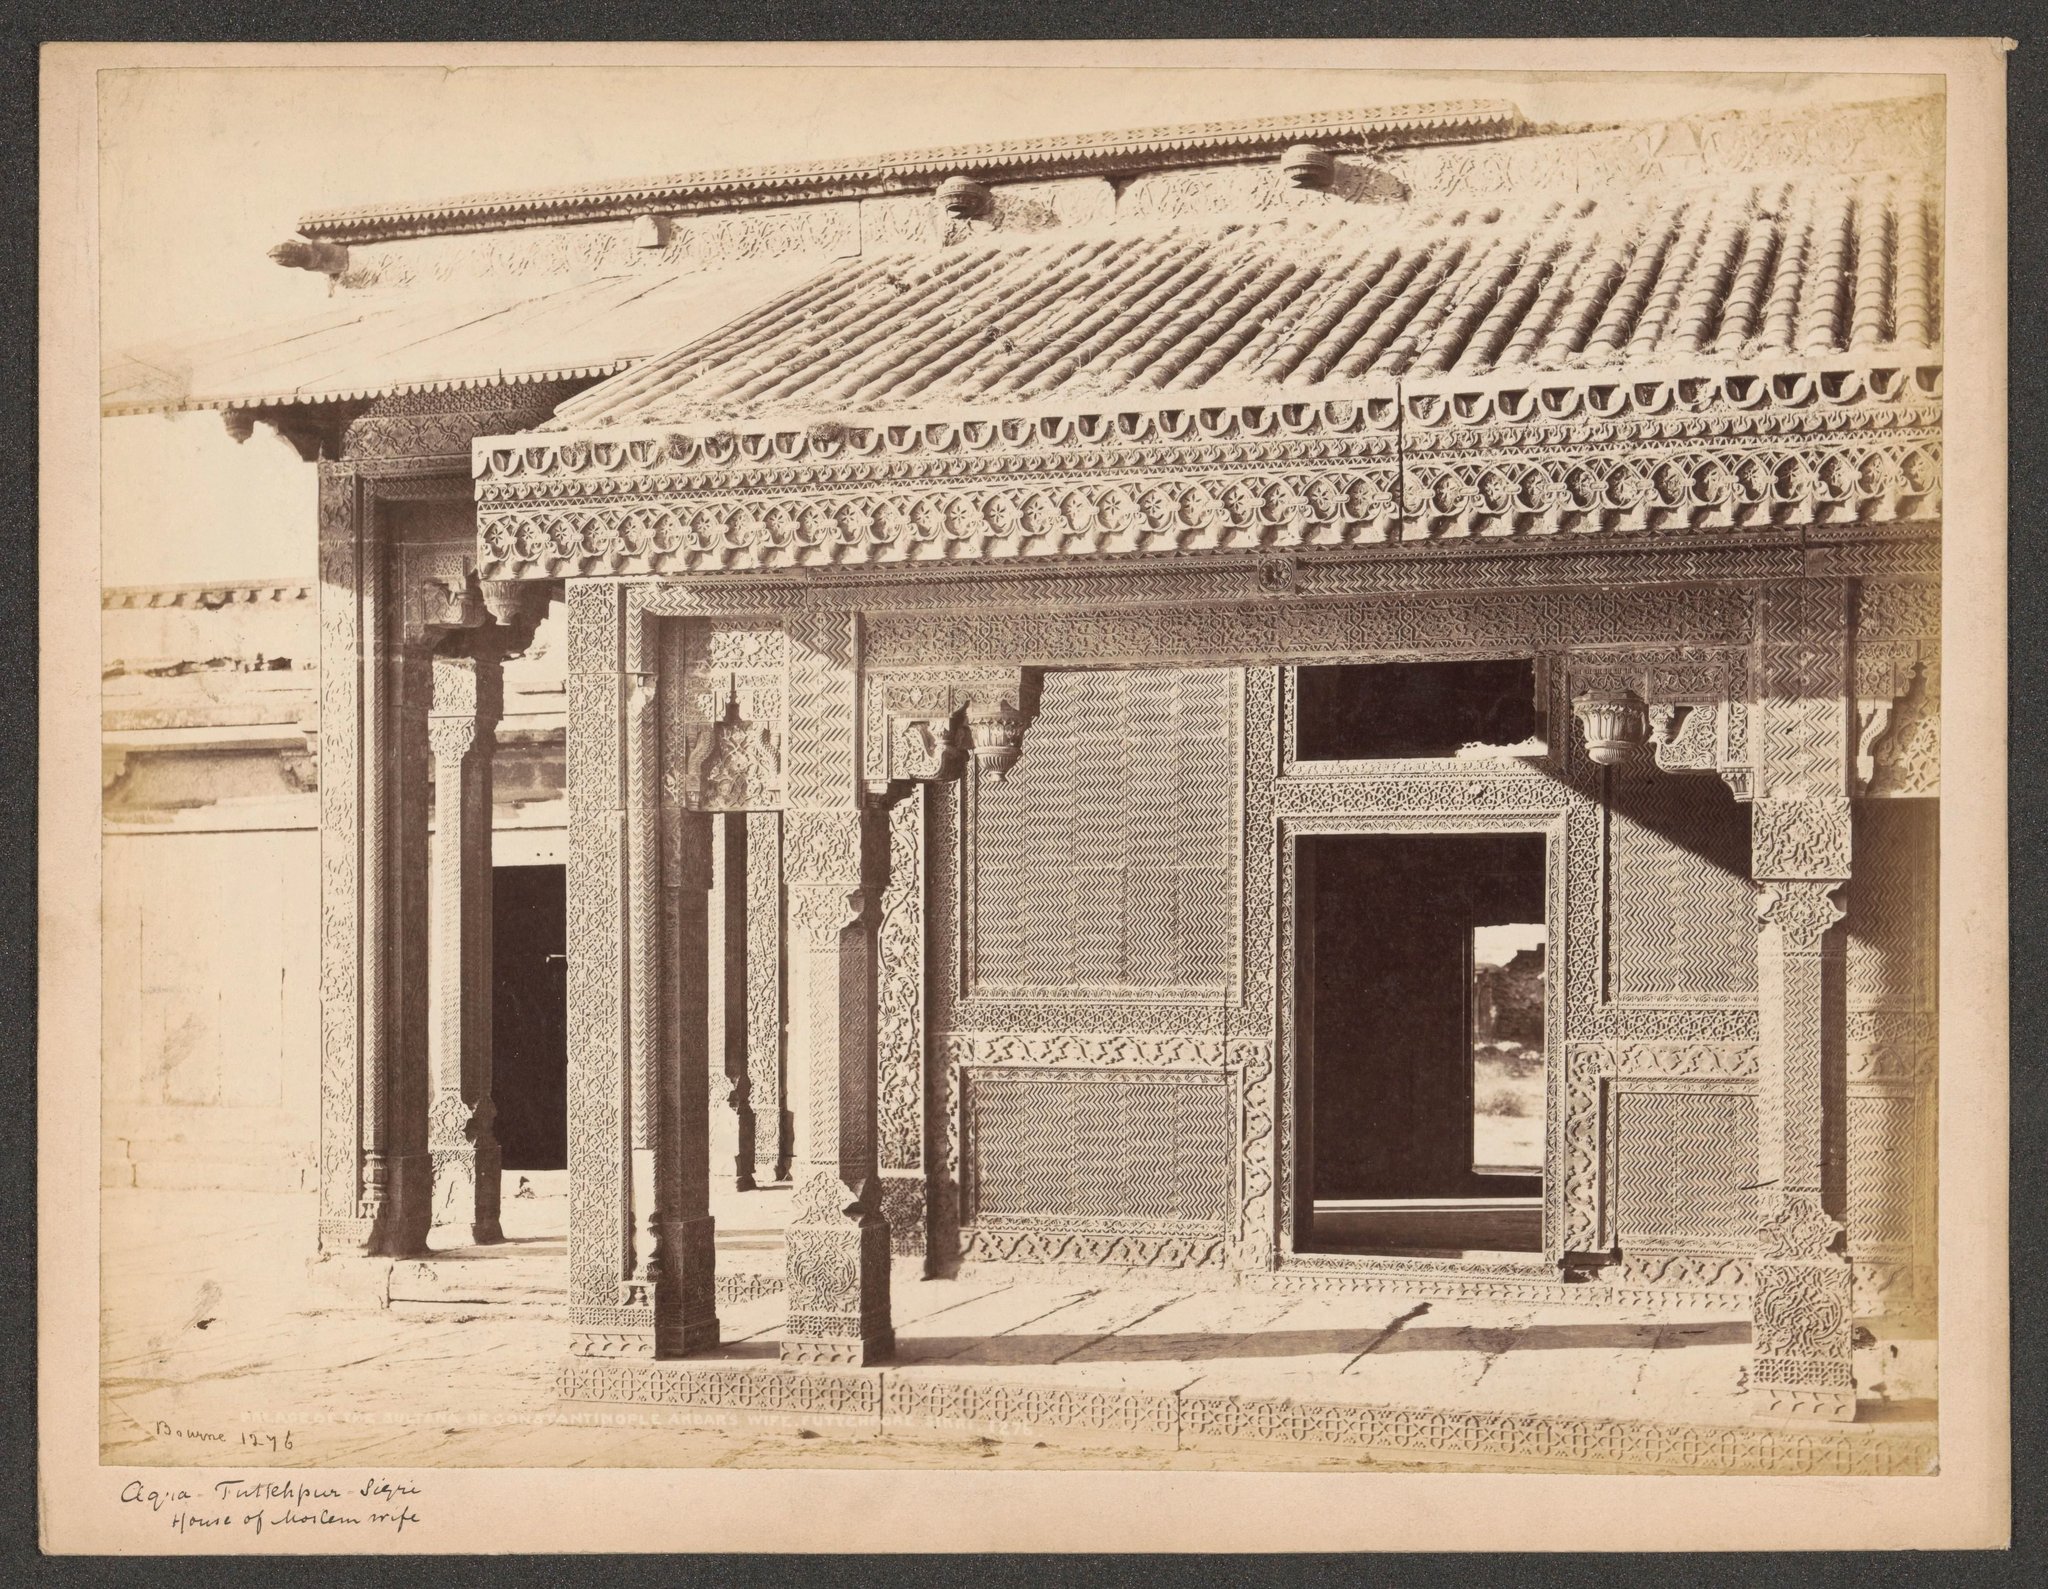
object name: photograph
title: Palace of the Turkish sultana in Fatehpur Sikri, Uttar Pradesh, India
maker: samuel bourne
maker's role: fotograaf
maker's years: 1834-1912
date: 1863-1865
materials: cardboard, paper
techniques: albumen print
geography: fatehpur sikri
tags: palace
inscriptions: number: ‘62’, inscription: ‘Agra Futtehpur Sigri/ House of Moslem Wife’, name: ‘Bourne’, number: ‘1276/ 1276’, title: ‘Palace of the Sultana of Constantinople Akbar's wife. Futtehpore Sikri.’